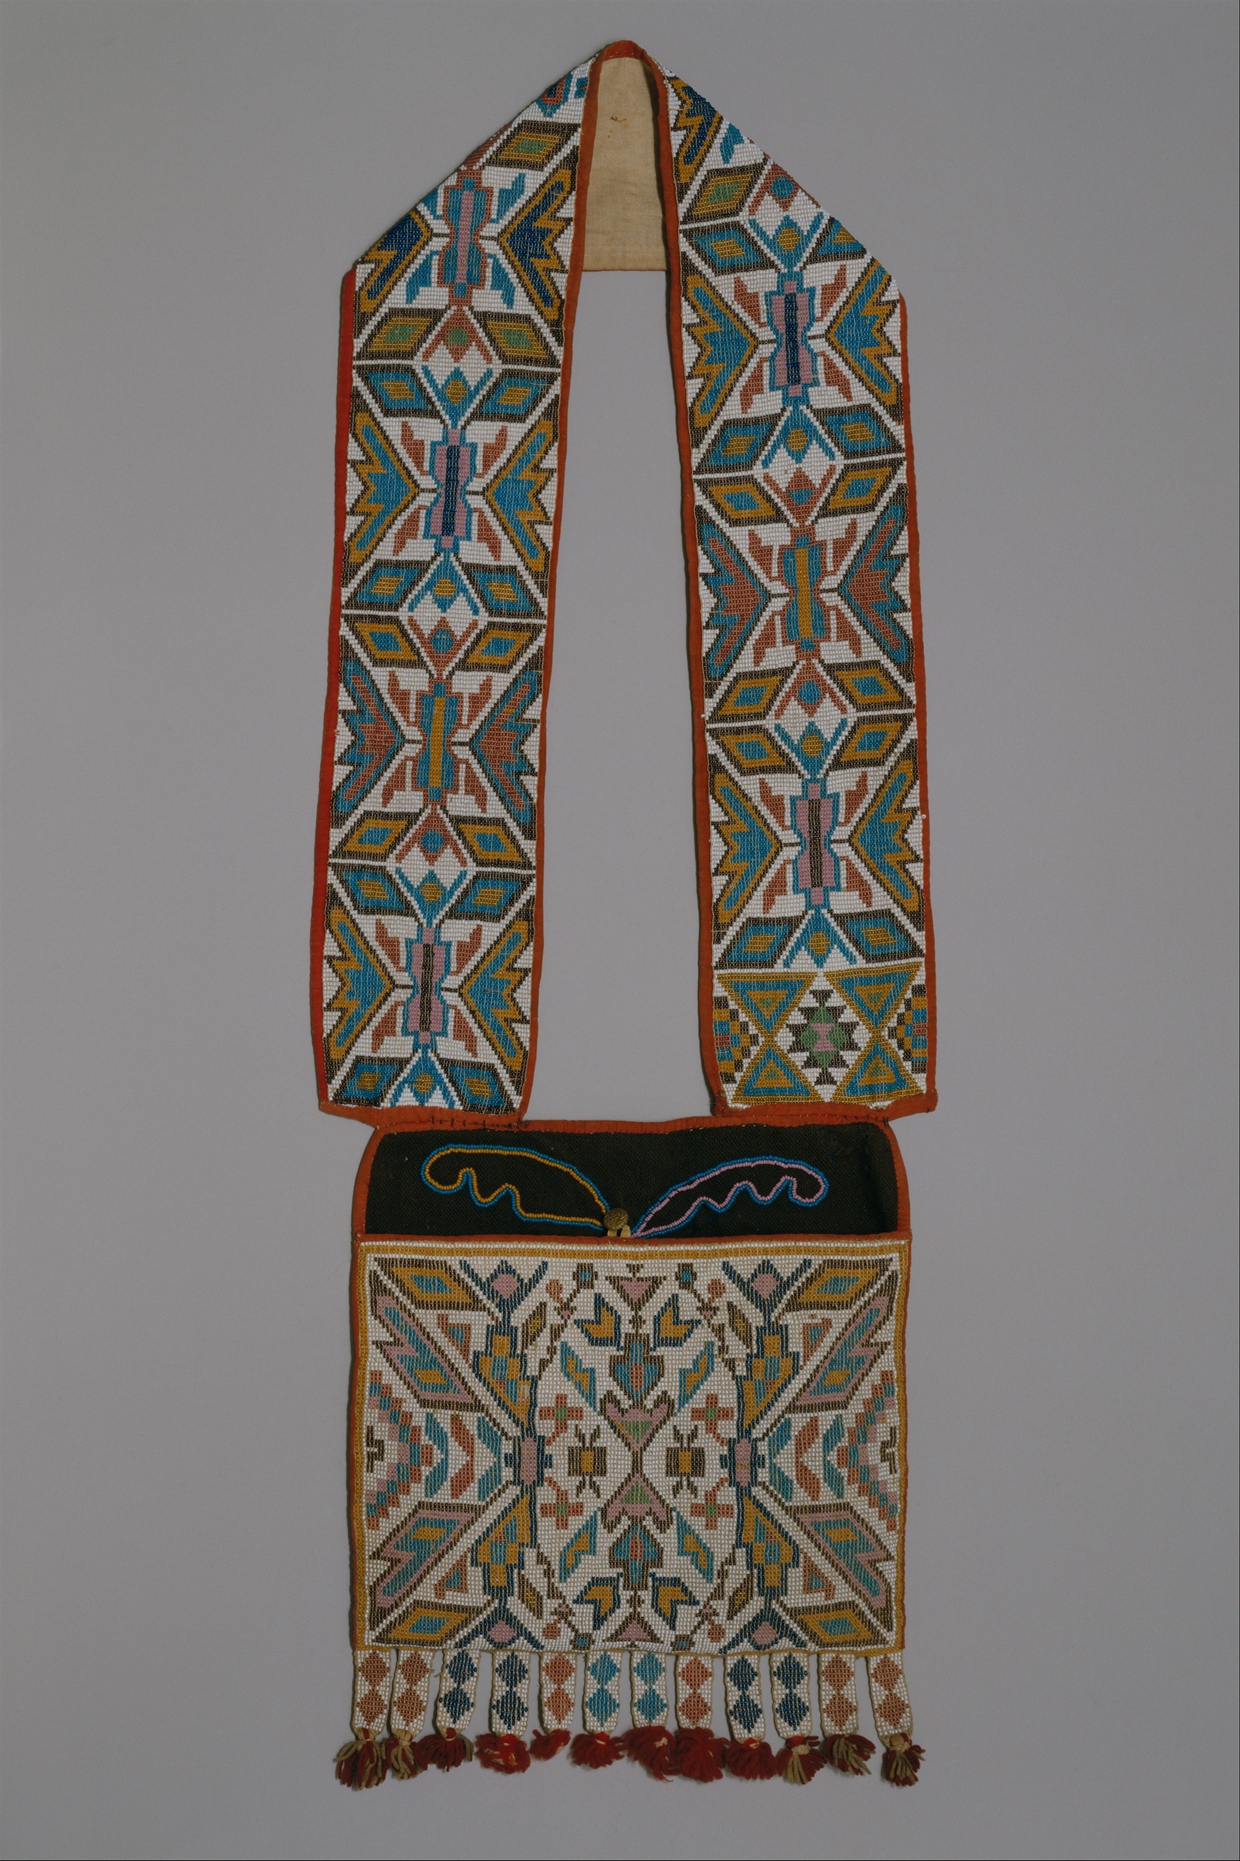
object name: bag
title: Bandolier Bag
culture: ho-chunk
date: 1880-1889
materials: textile, cotton, glass, metal, wool, thread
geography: united states